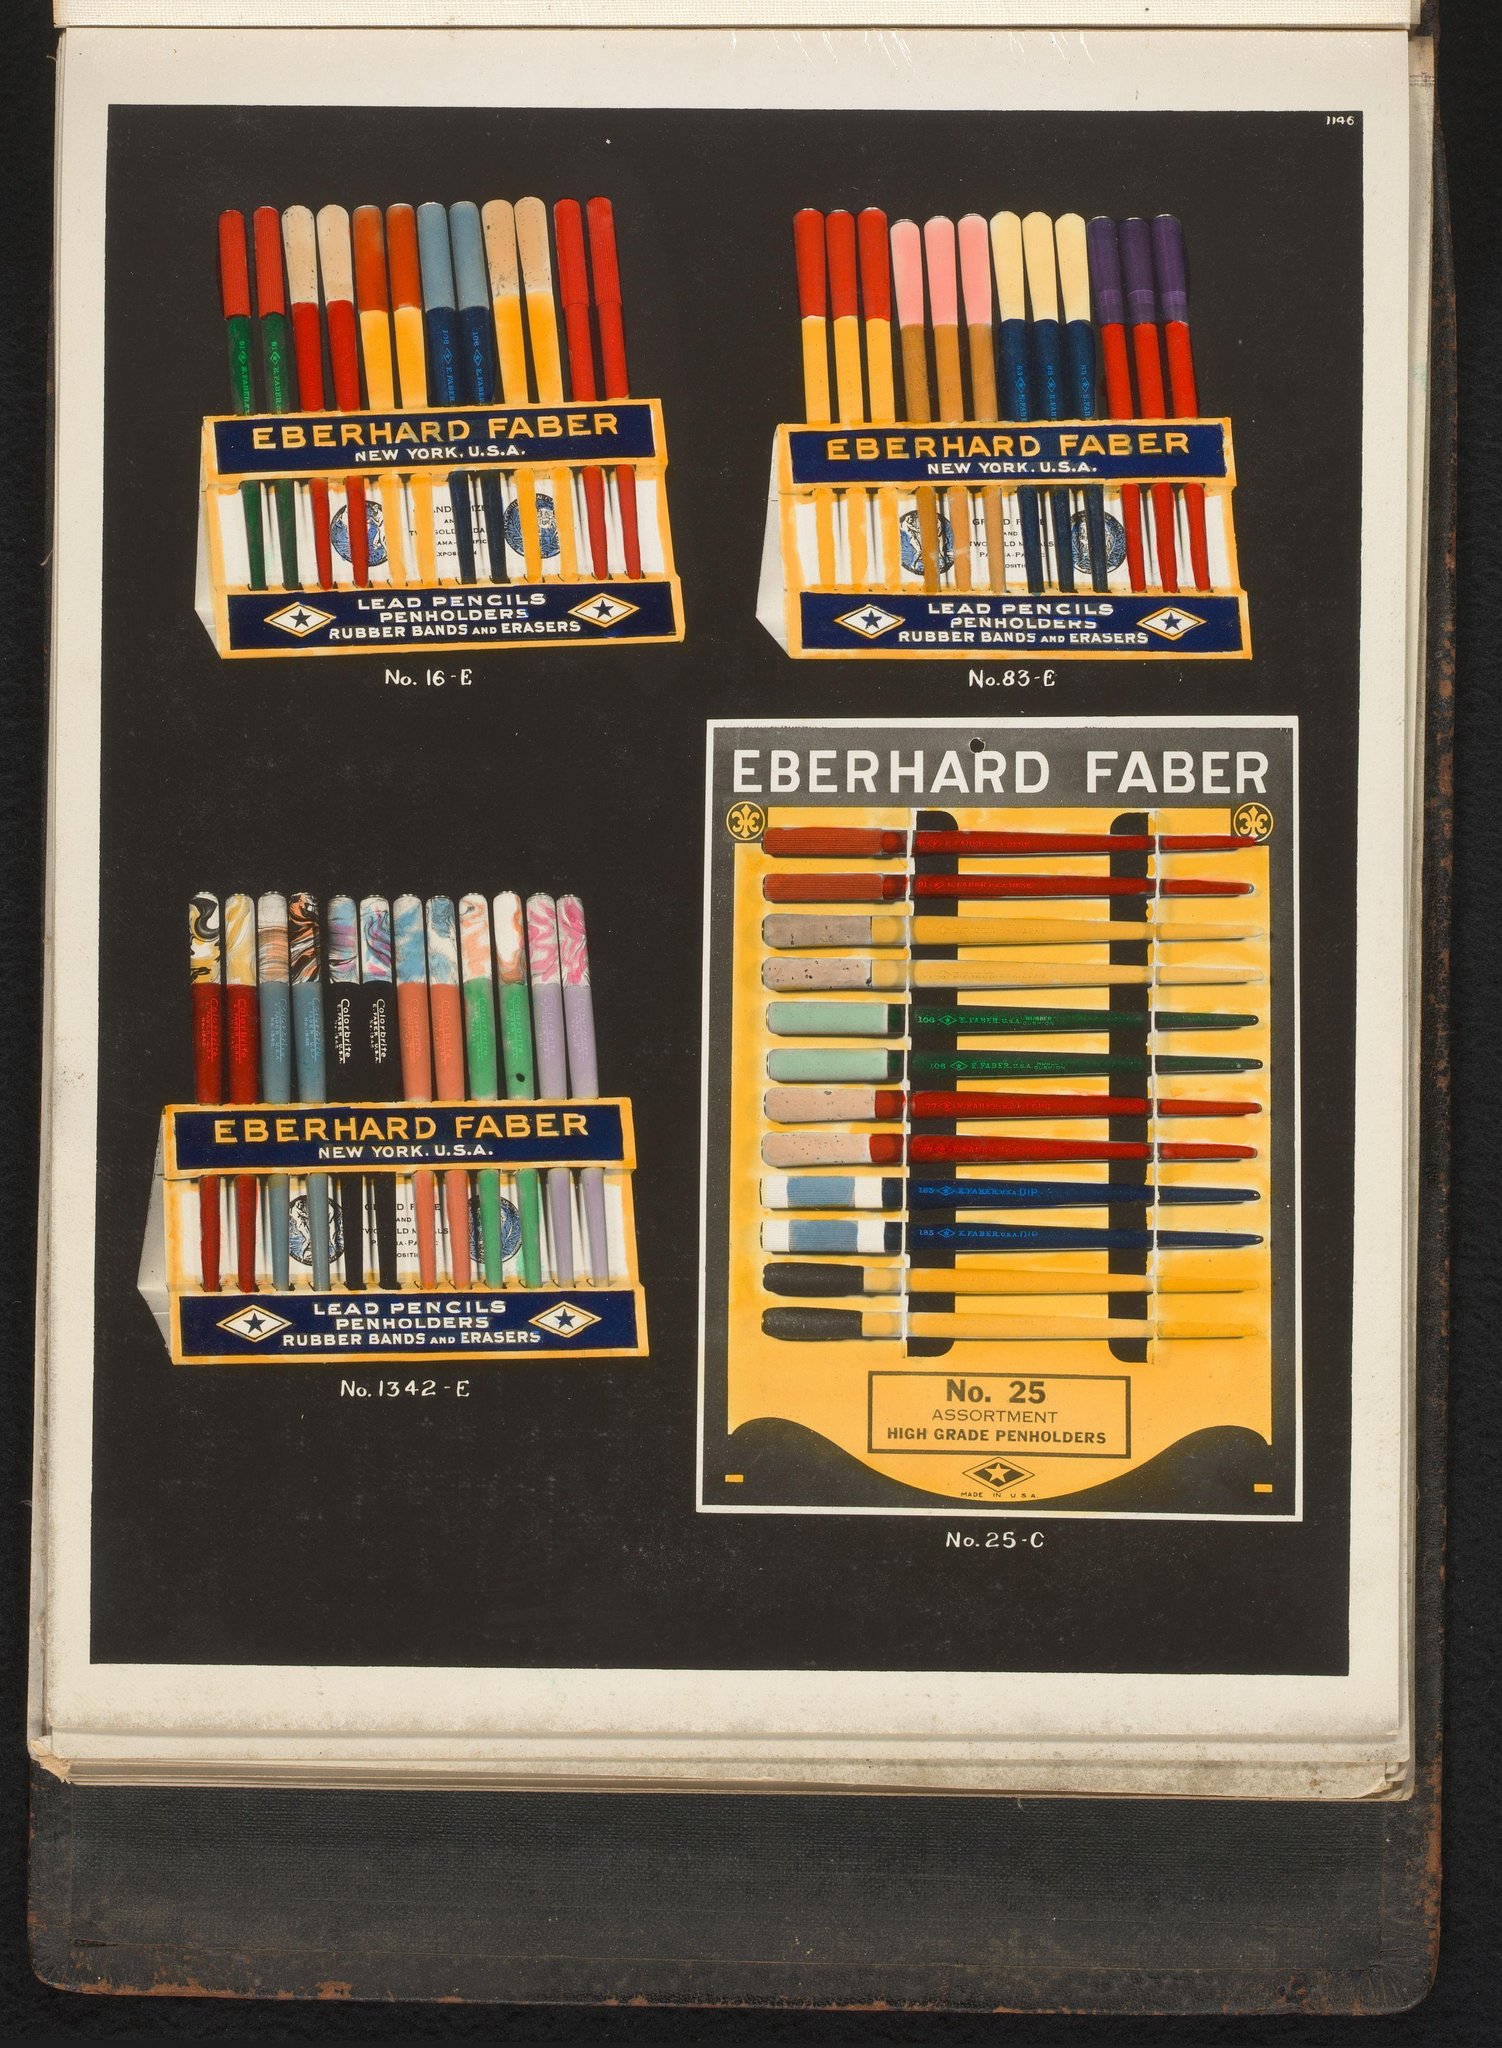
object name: photograph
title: Standaarden met potloden en pennen van Eberhard Faber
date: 1915-1935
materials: paper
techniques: gelatin silver print, hand coloring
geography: springfield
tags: writing tools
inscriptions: number: ‘1146’, stamp: ‘Paramount/ Commercial Studios/ 145 Chestnut St./ Springfield - Mass.’